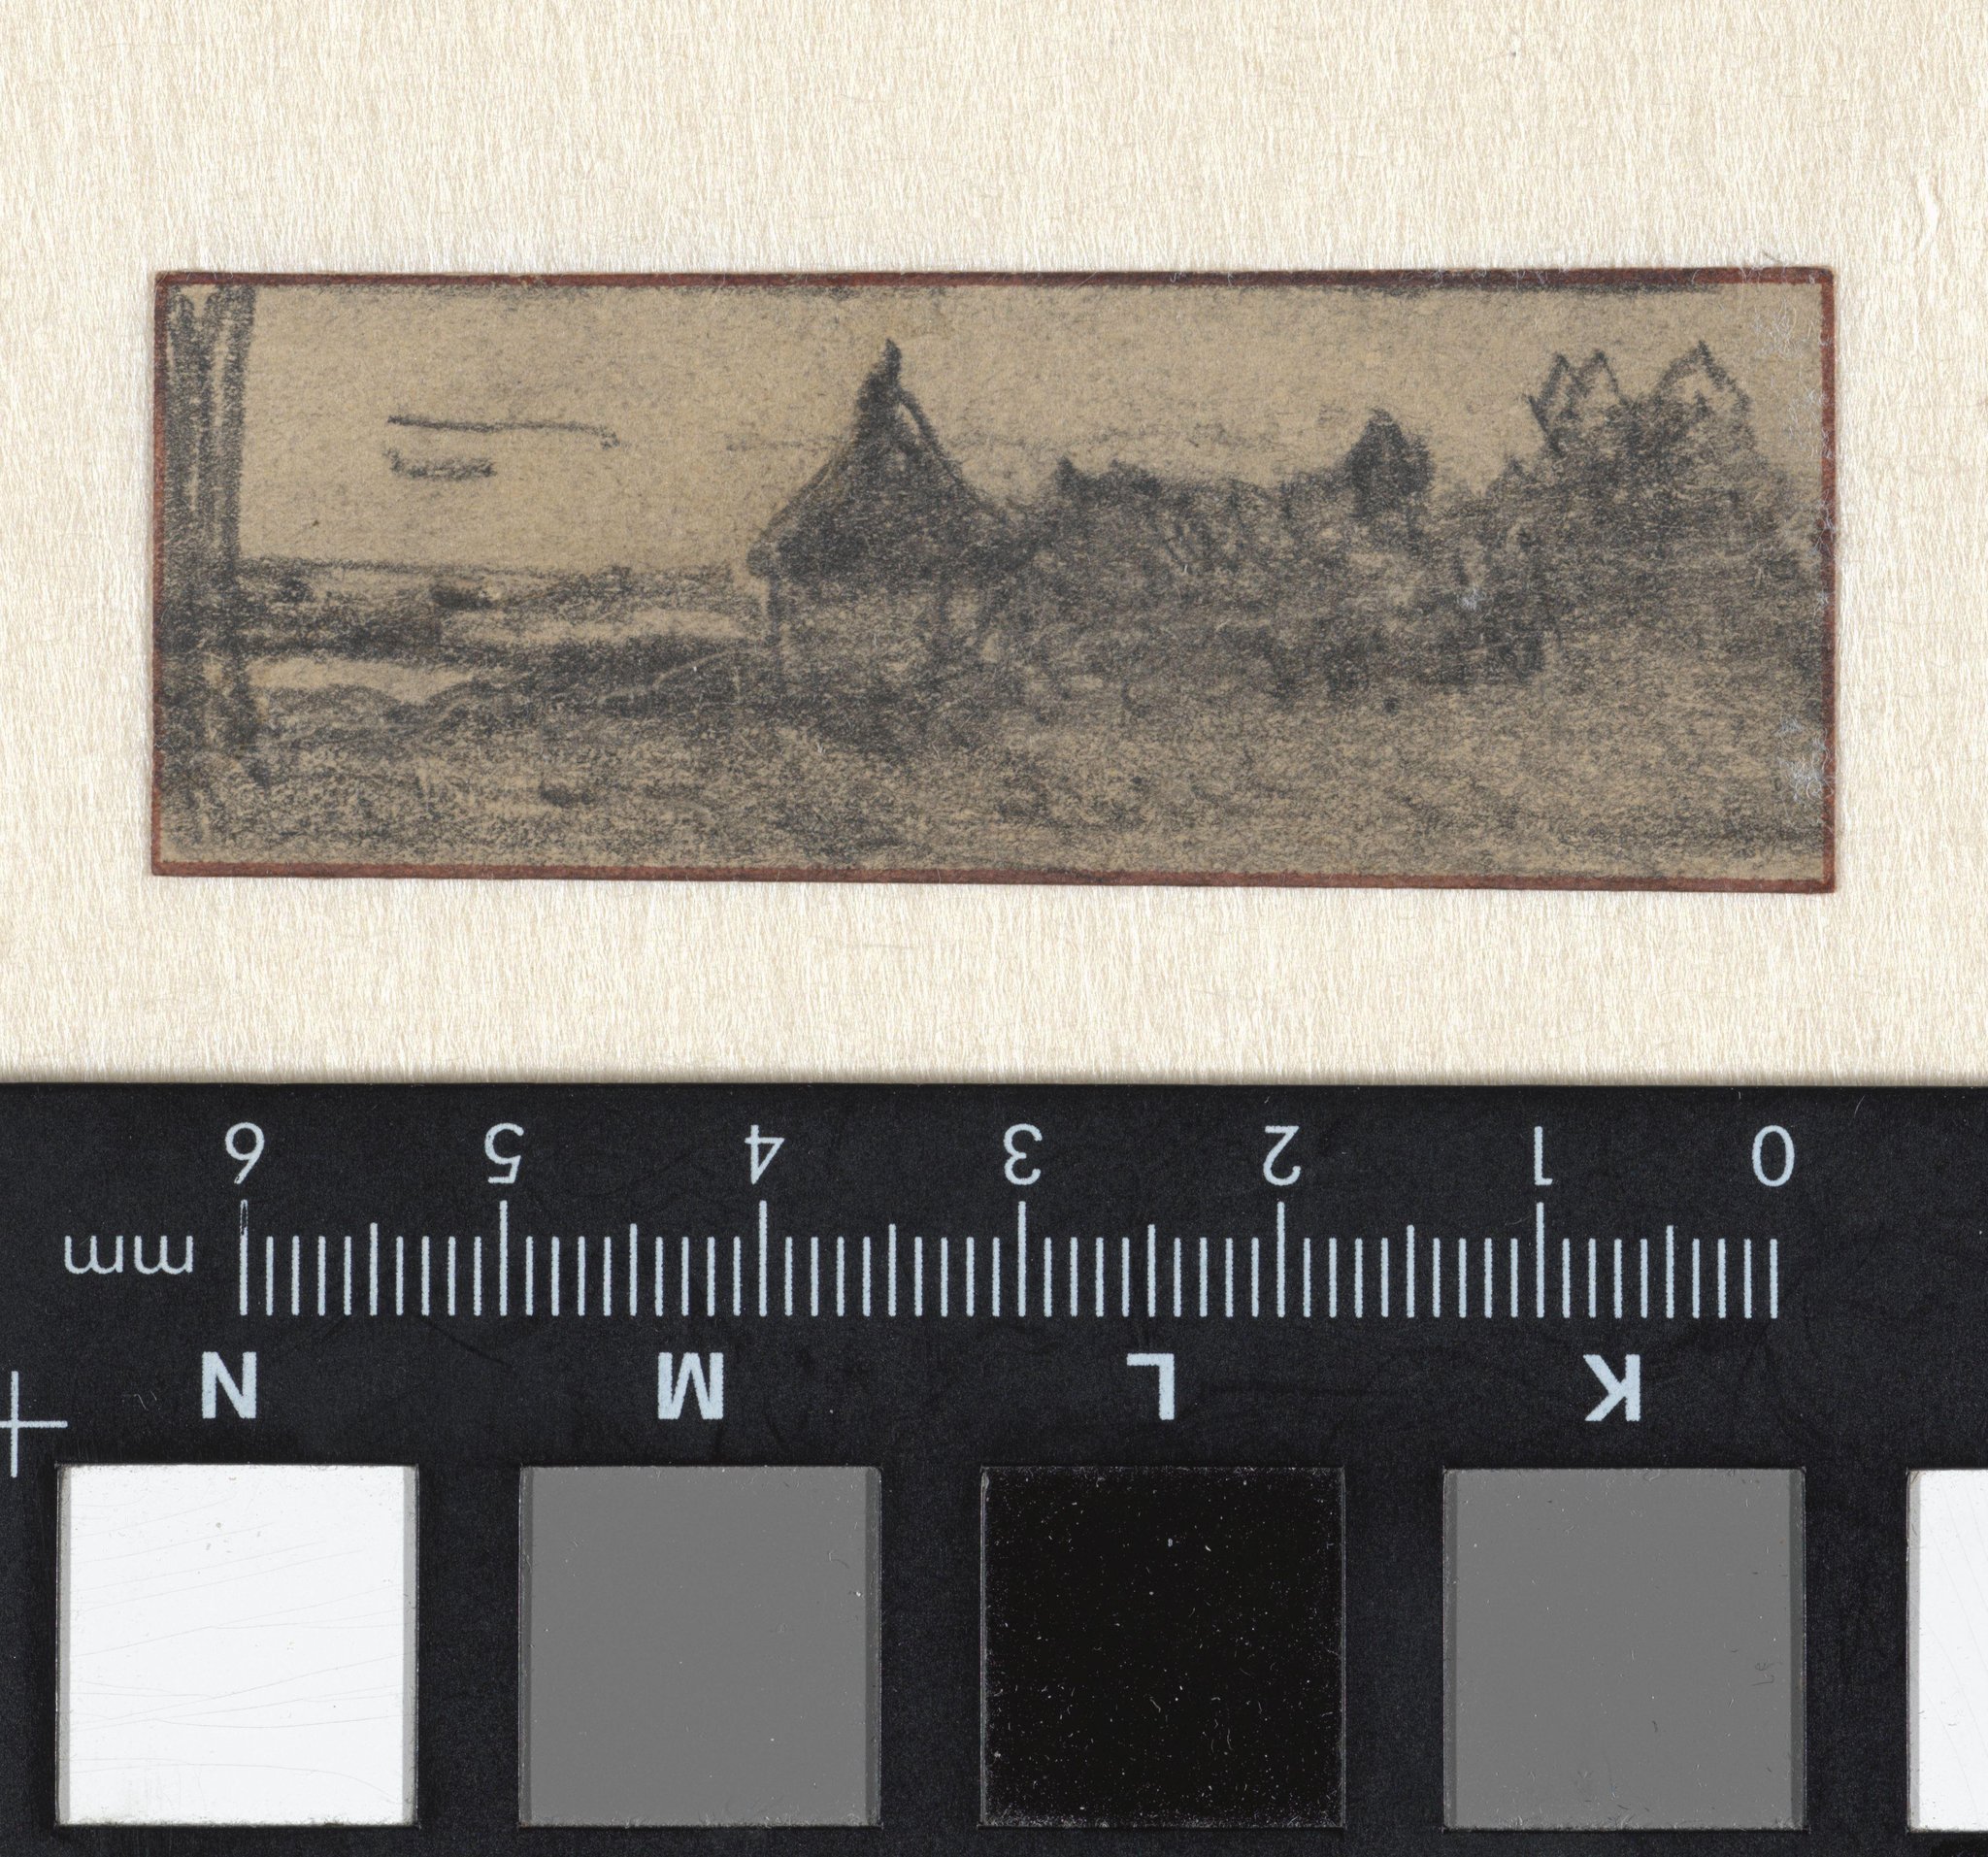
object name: drawing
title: Schets van een landschap met huis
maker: willem roelofs (i)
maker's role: draughtsman, painter, print maker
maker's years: 1822-1897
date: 1832-1897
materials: paper, pencil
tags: farm or solitary house in landscape